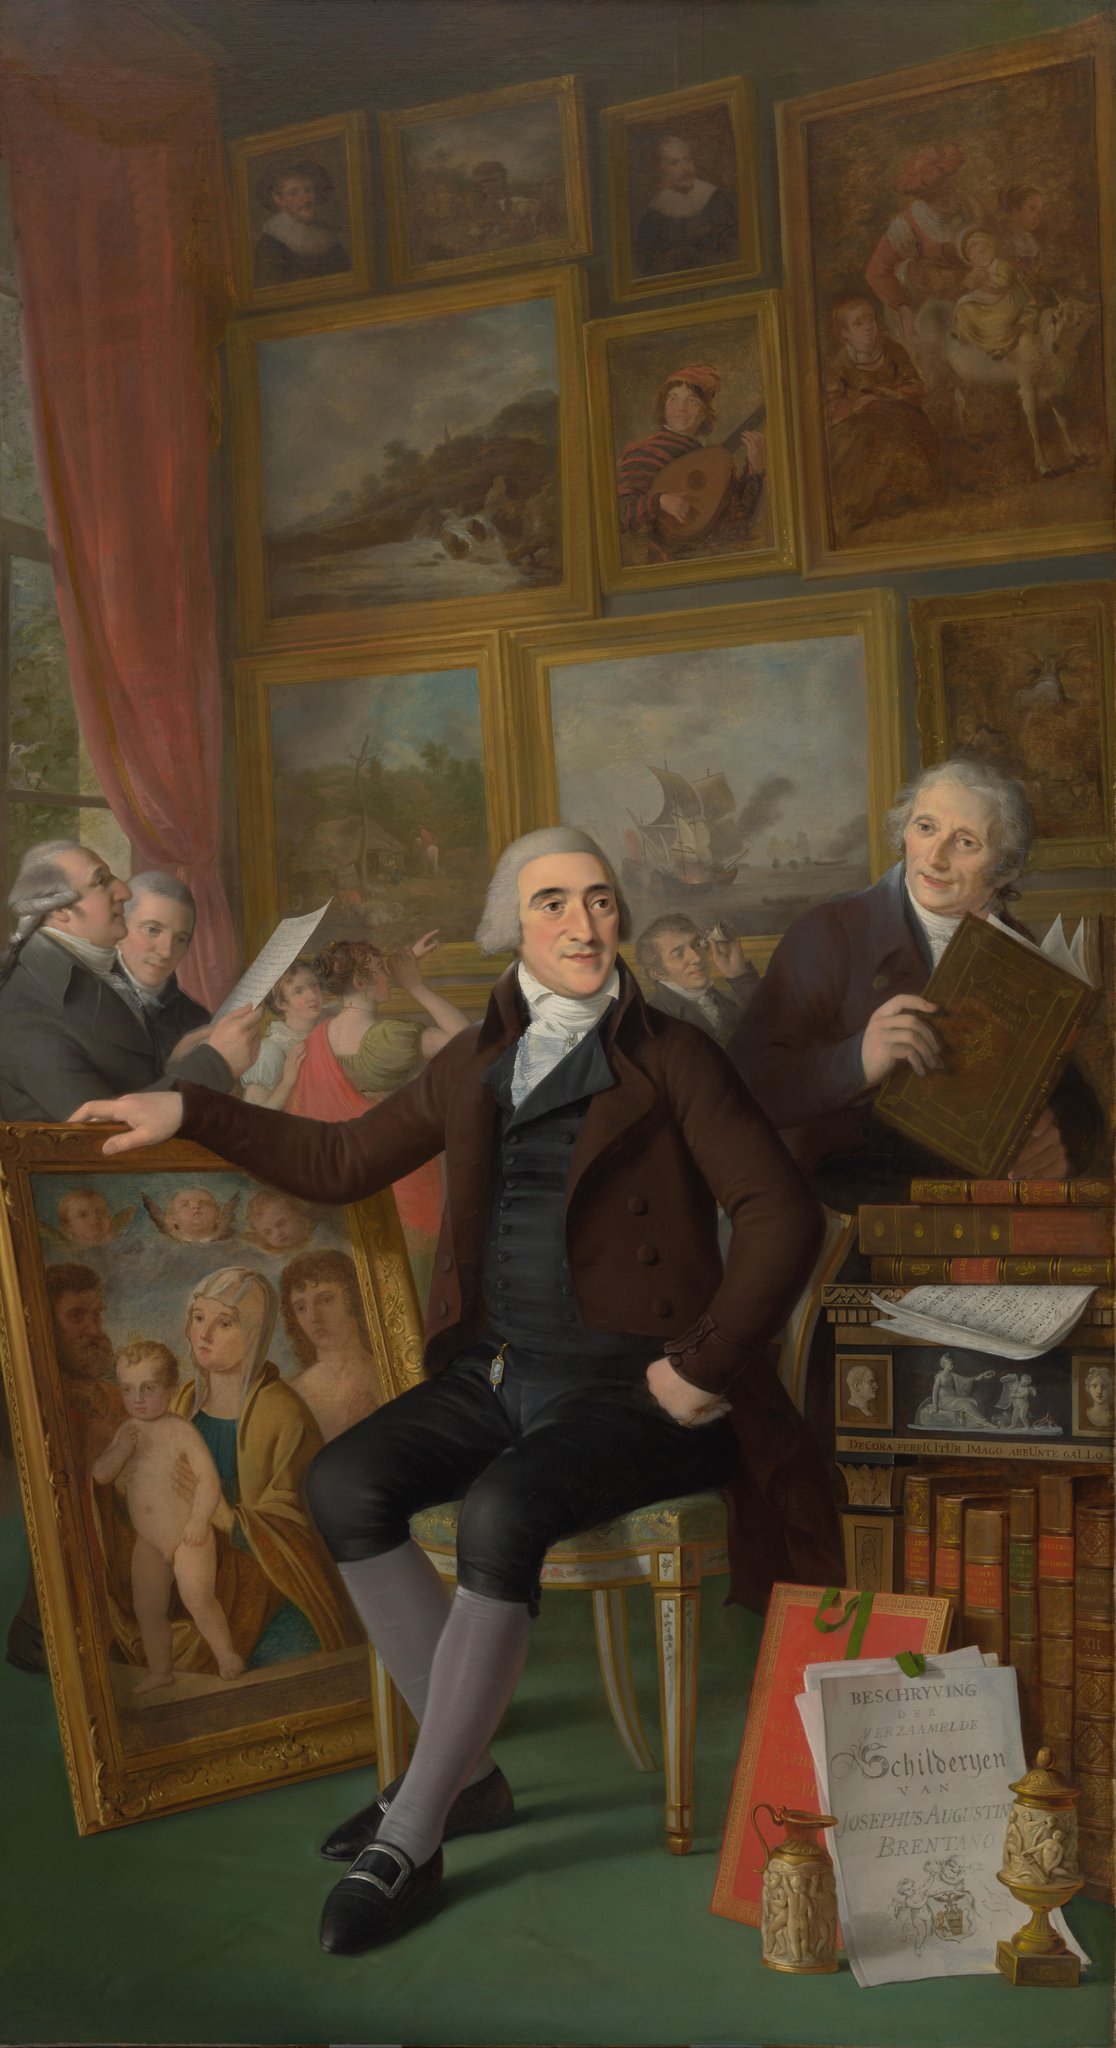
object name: painting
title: Portrait of the Collector Josephus Augustinus Brentano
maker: adriaan de lelie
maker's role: draughtsman, painter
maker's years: 1755-1820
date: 1813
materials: canvas, oil, paint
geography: amsterdam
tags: amsterdam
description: The art collector Brentano is here presenting his finest pieces. His hand rests on a 15th-century Italian painting by Giovanni Bellini. The wall behind him is covered with Dutch 17th-century masterpieces. The landscape at the lower left by Adriaen van de Velde was acquired by the Rijksmuseum as early as 1822. On the right we see De Lelie, the painter of the portrait, conversing with his patron Brentano and leafing through a book of artists’ biographies.